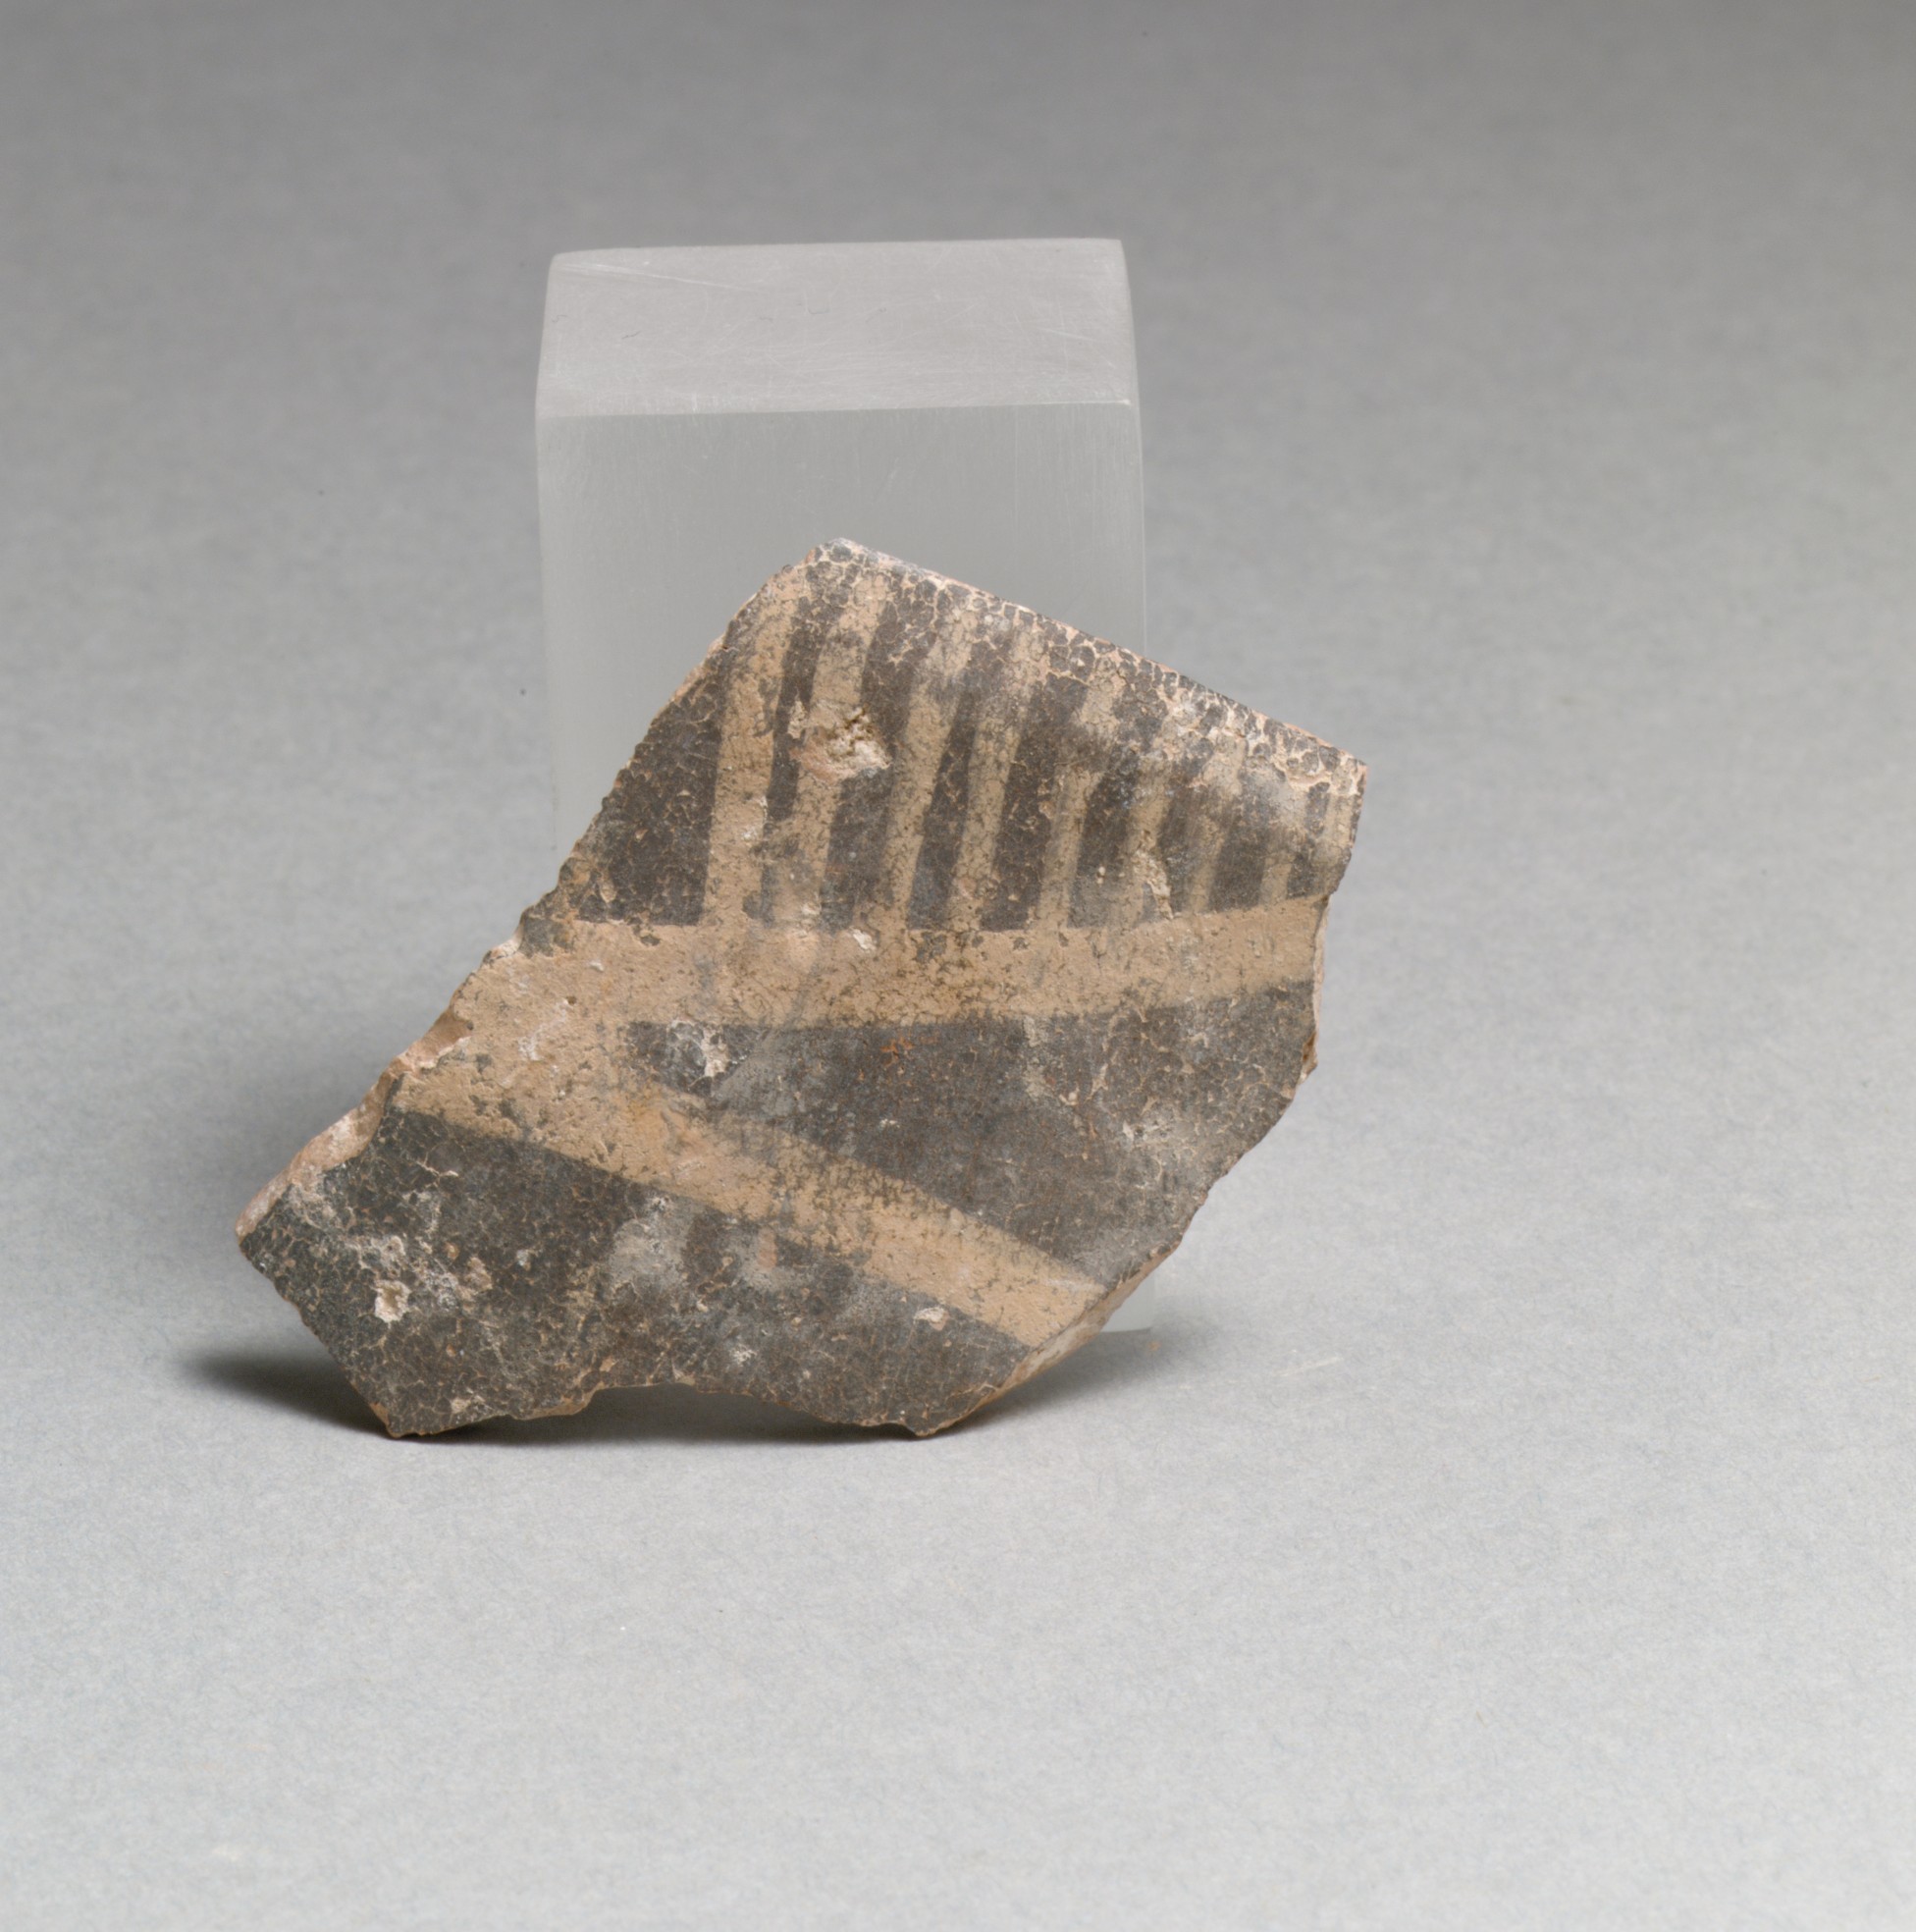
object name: vase fragment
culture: minoan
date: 2600-2000 BCE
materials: terracotta